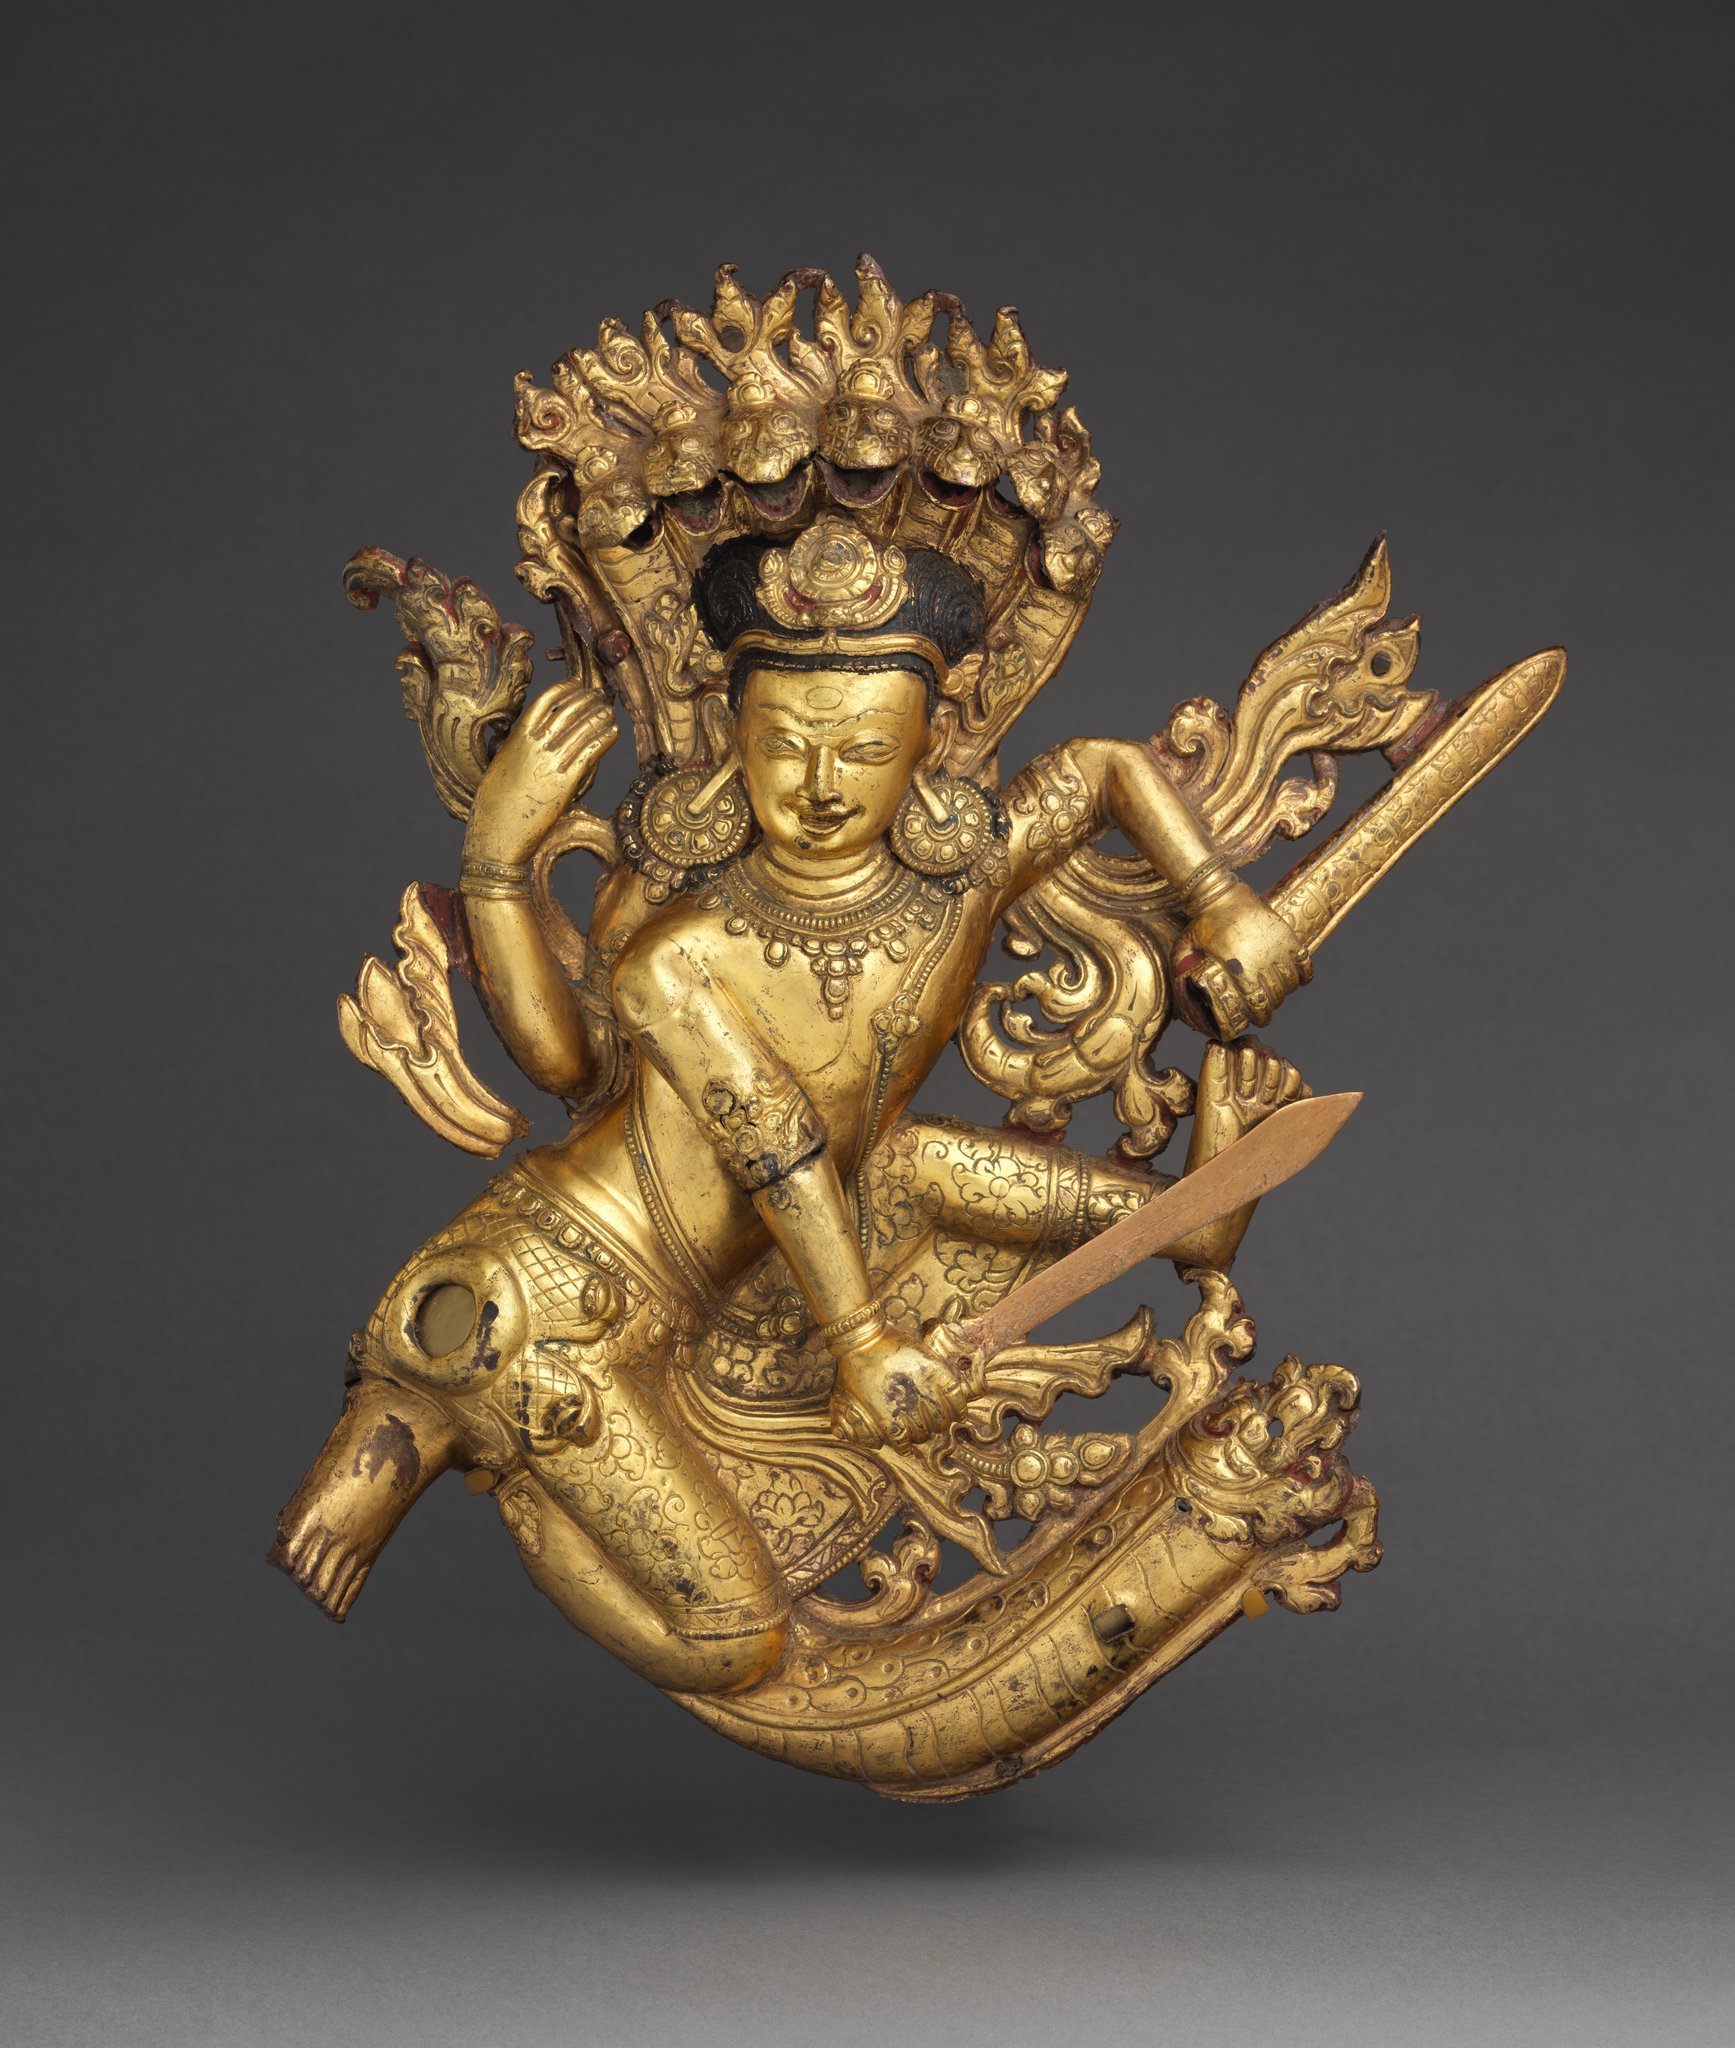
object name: figure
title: Krishna subduing the Naga Kaliya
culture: nepali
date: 1601-1700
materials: copper gilt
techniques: repoussé